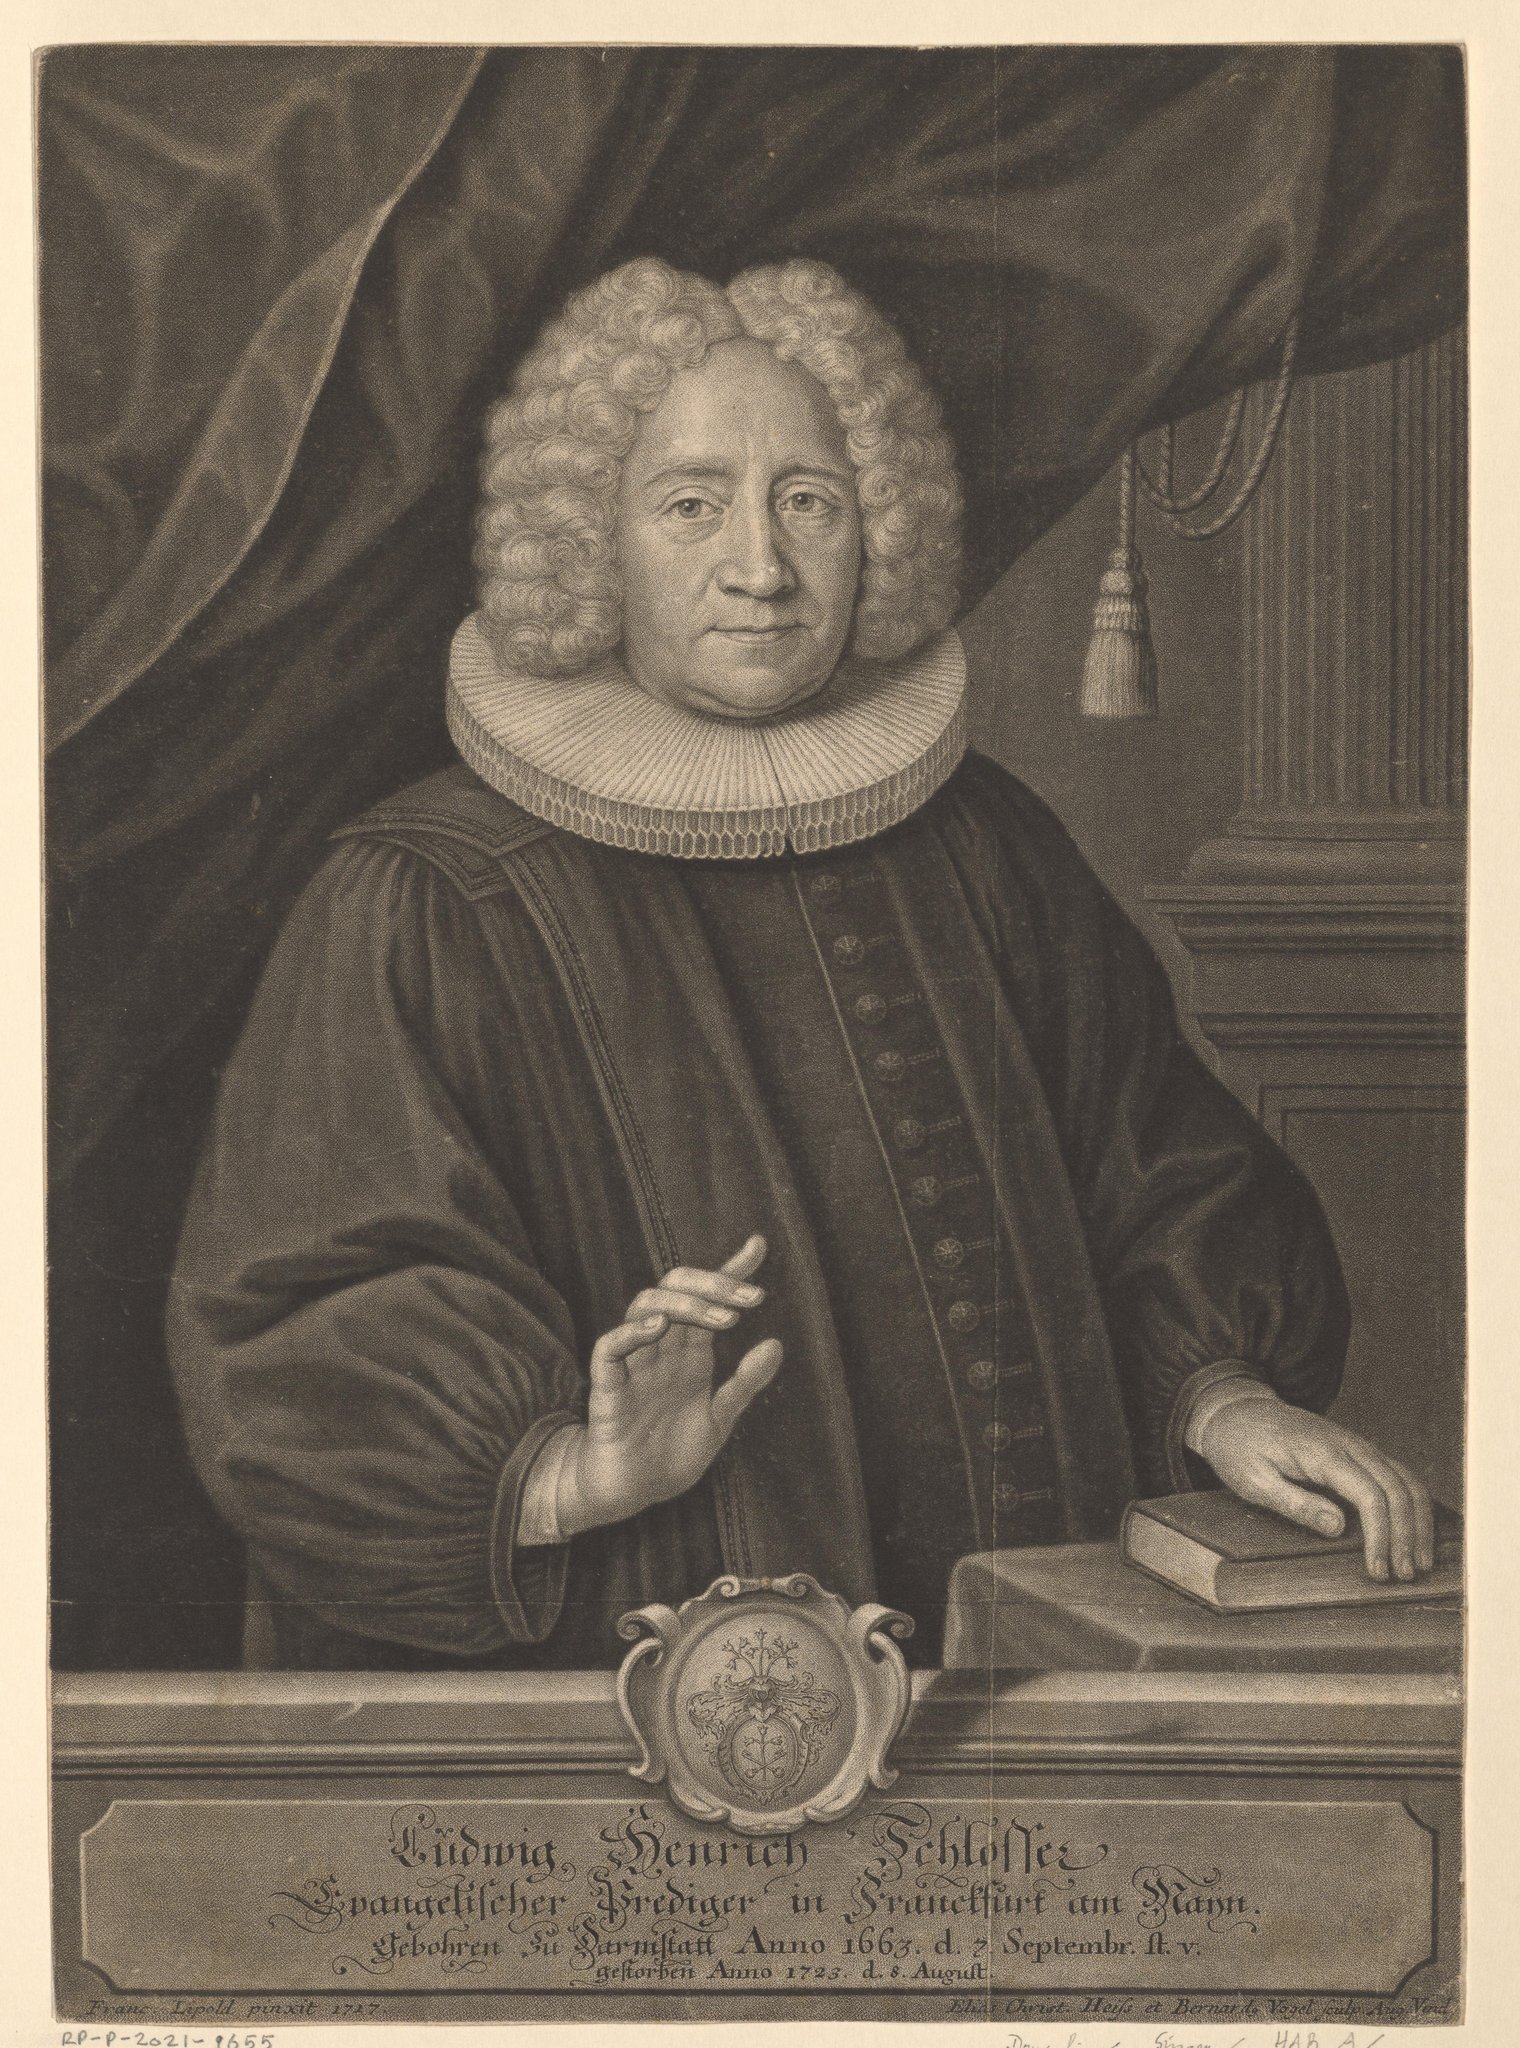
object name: print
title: Portret van Ludwig Heinrich Schlosser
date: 1723-1731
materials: paper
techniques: etching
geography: augsburg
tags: priest, historical persons, book, armorial bearing, heraldry